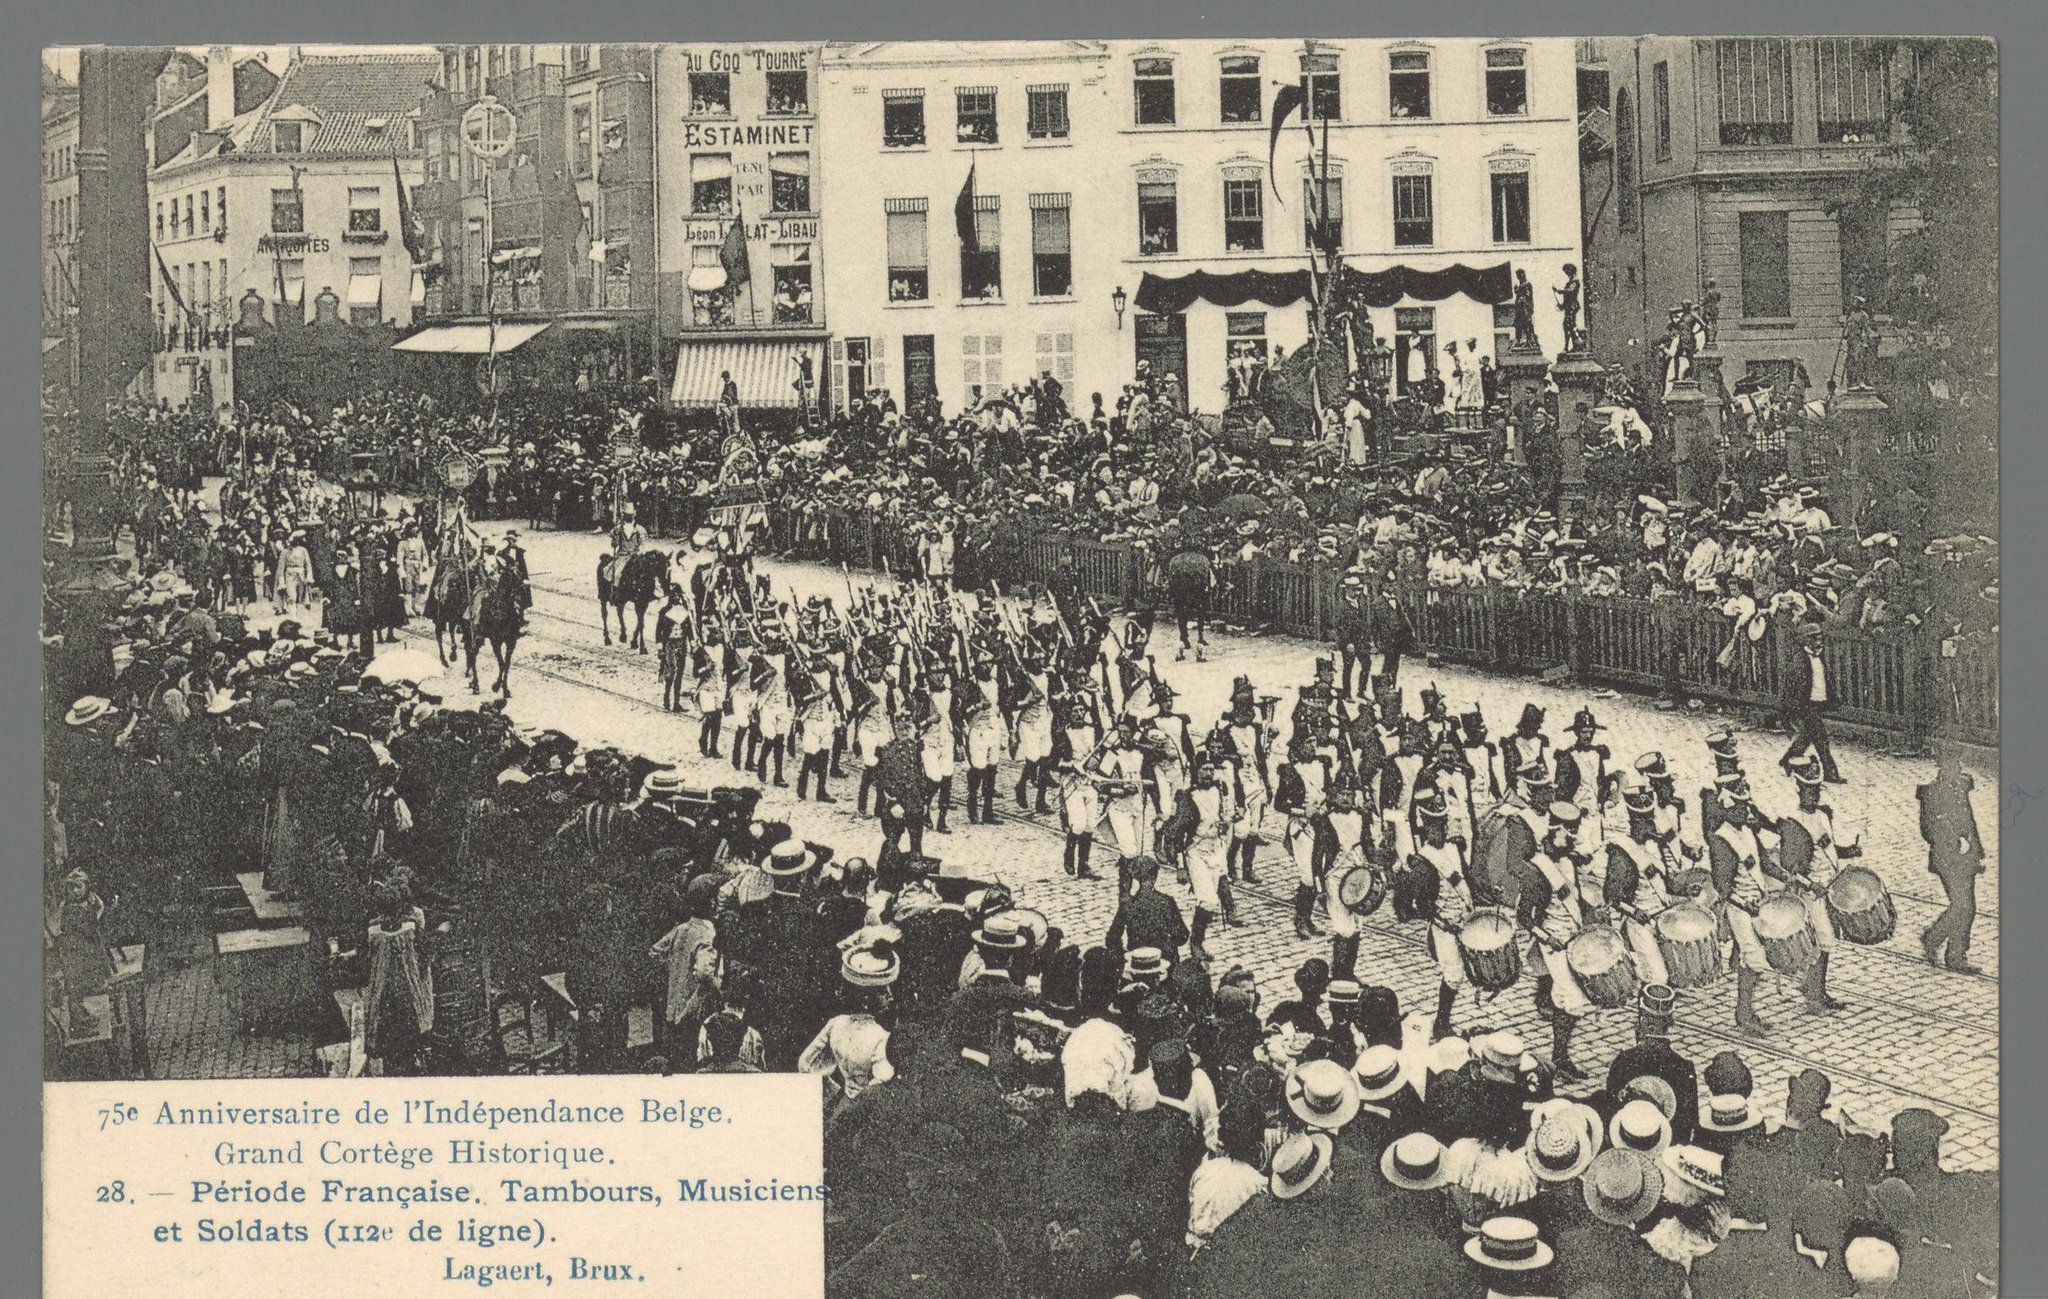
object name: ansichtkaart, prentbriefkaart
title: Période Française. Tambours, Musiciens et Soldats (112e de ligne)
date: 1905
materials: cardboard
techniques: photograph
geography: brussels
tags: city-view, and landscape with man-made constructions (+ city(-scape) with figures, staffage), periodic celebrations, popular feasts, brussels